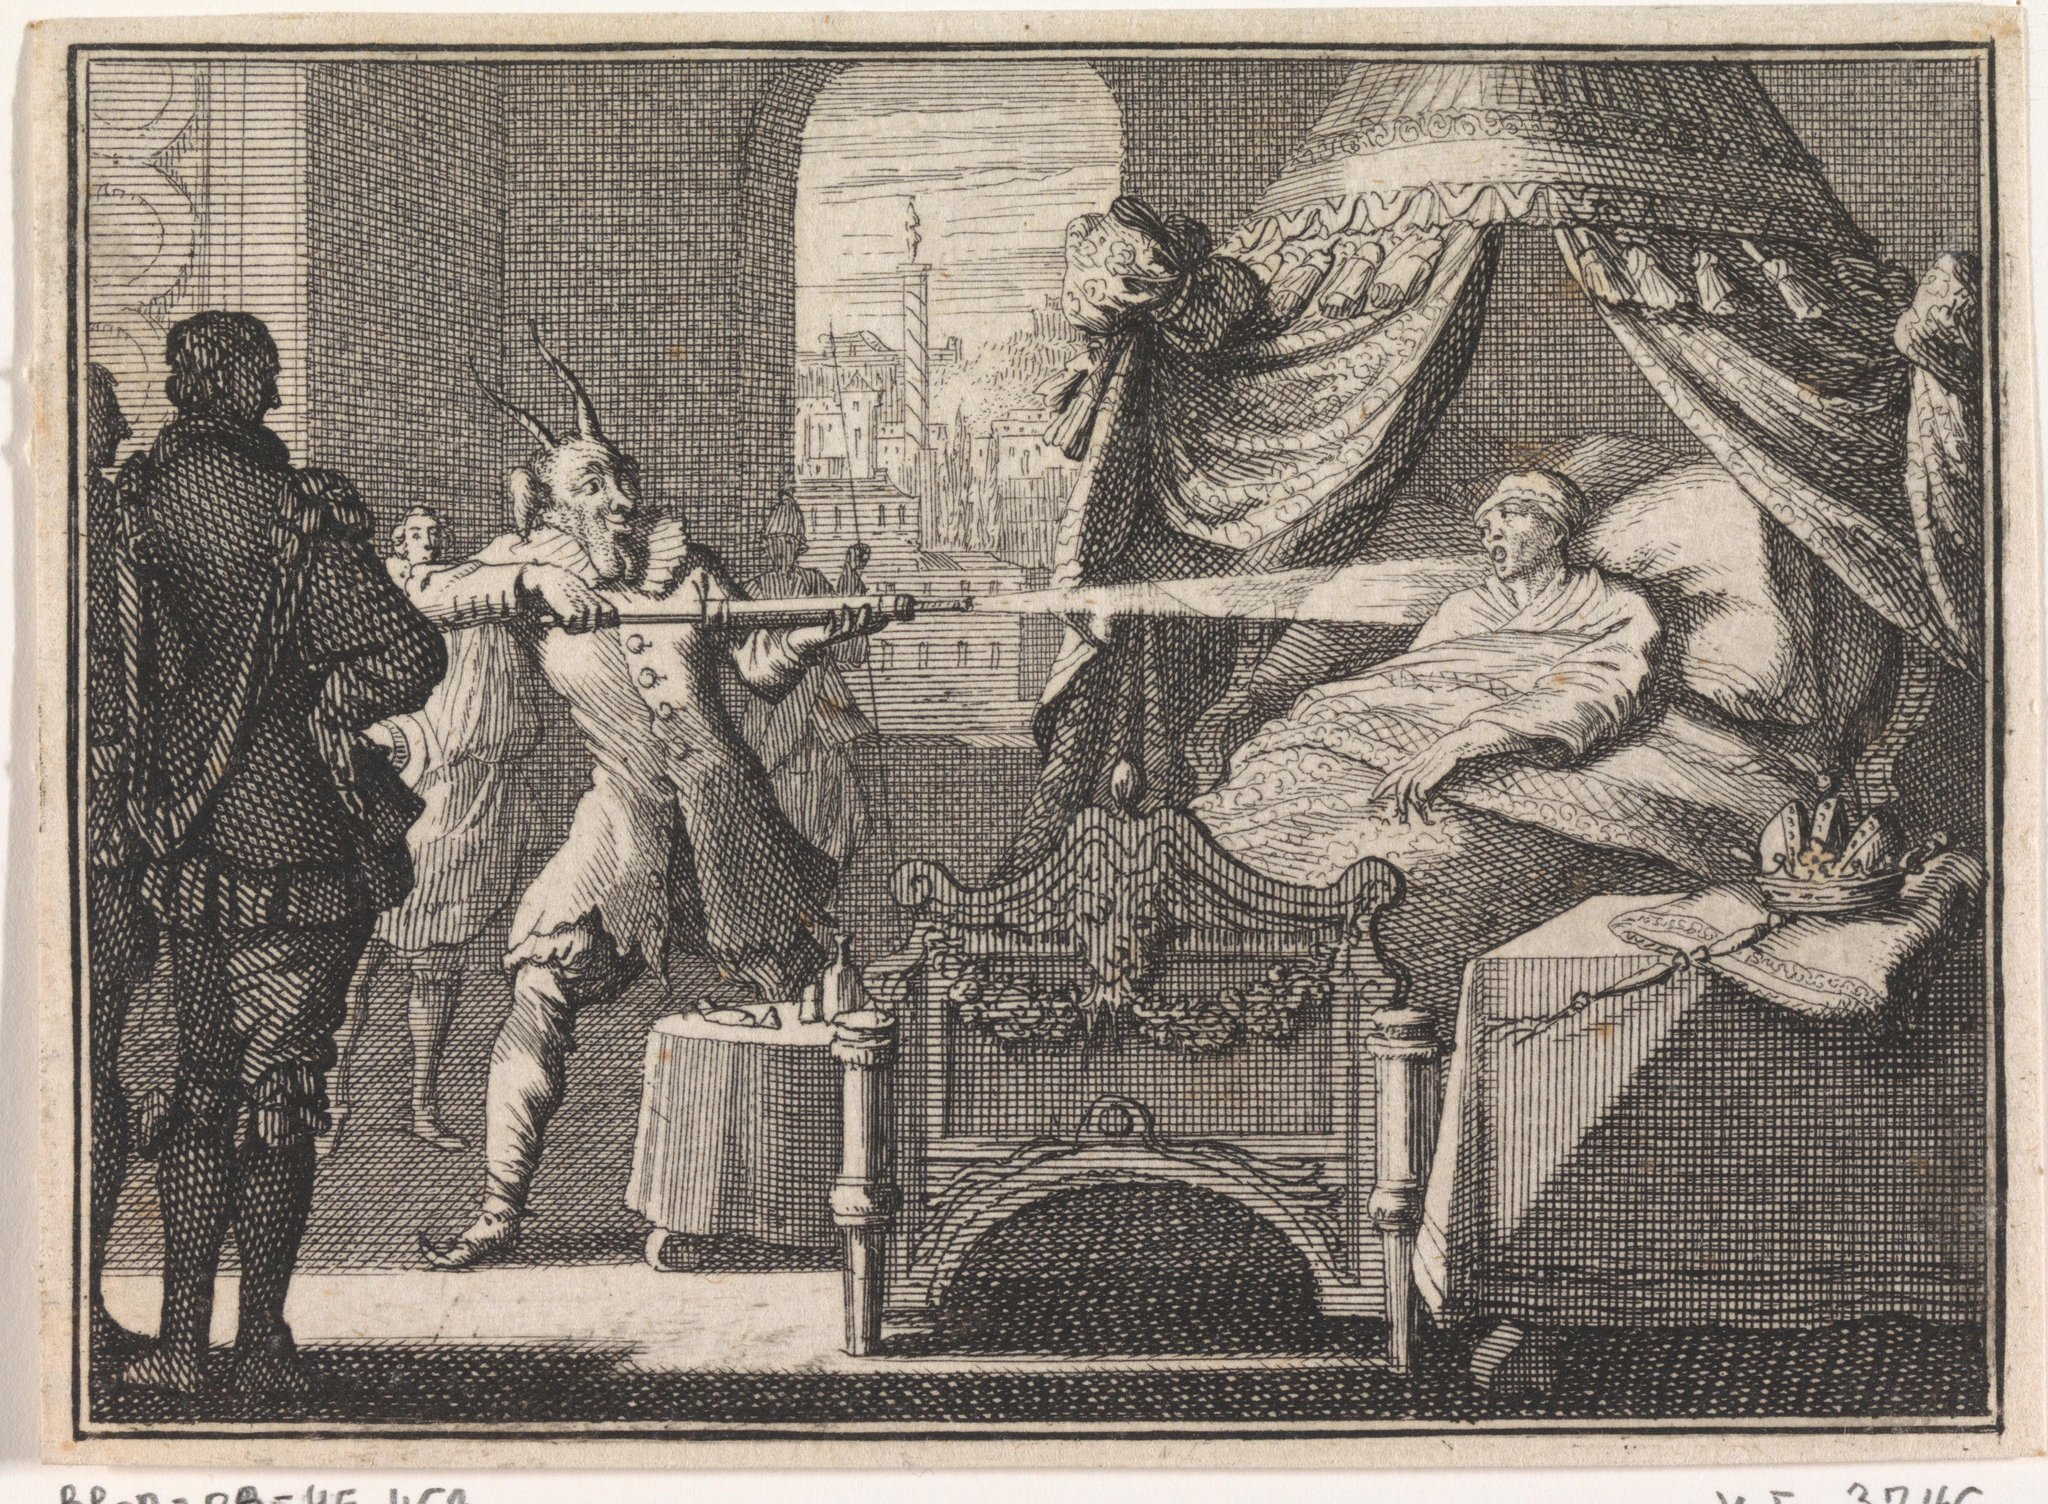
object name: print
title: Die Wahl geht nicht wohl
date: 1710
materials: paper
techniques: etching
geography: nuremberg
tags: spraying (of plants), sick-bed, activities of devil(s)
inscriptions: collector's mark: Lugt 240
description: Illustratie uit: Abraham a Sancta Clara. Heilsames Gemisch Gemasch, das ist: Allerley seltsame und verwunderliche Geschichten (...). Neurenberg: Christoph Weigel, 1710, p. 11.